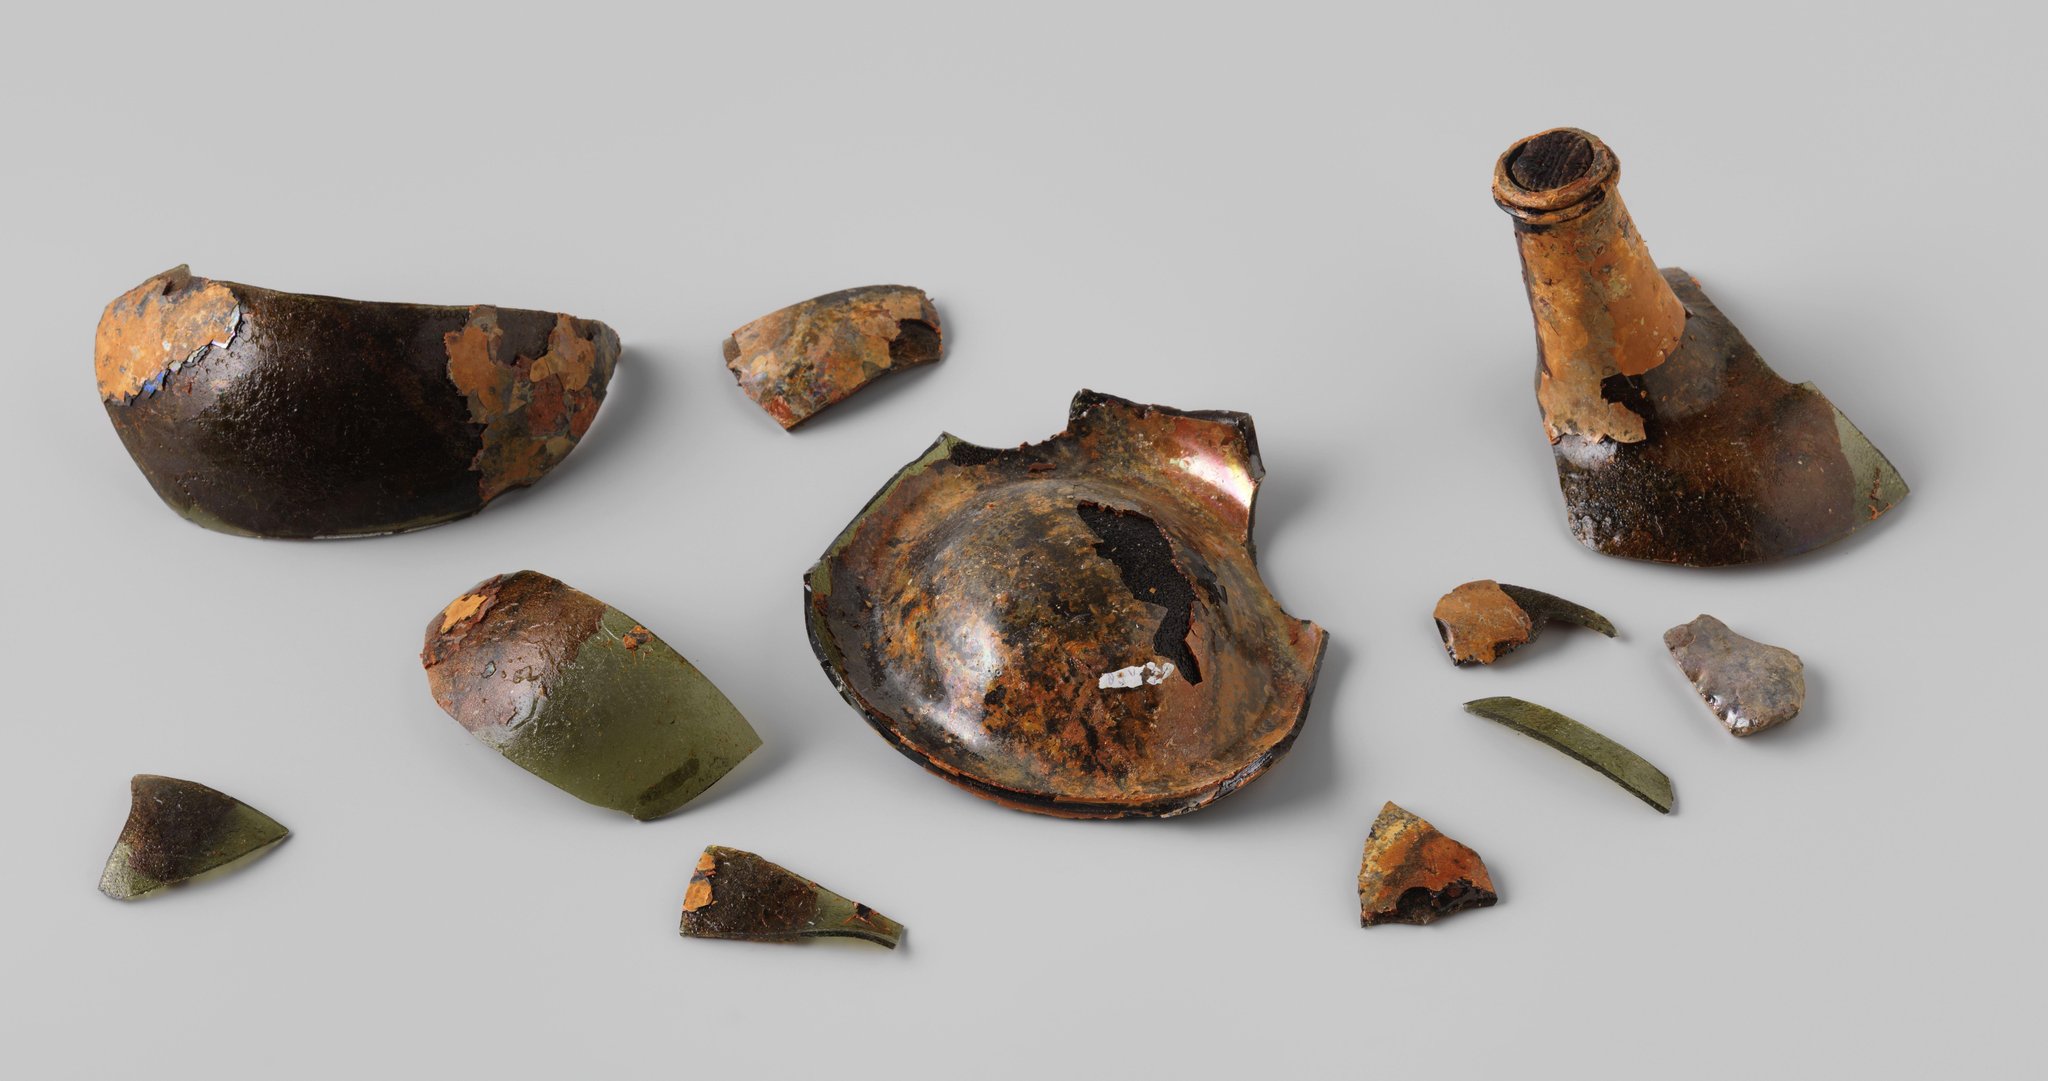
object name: sherd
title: Scherven van wijnflessen uit het wrak van de Oost-Indiëvaarder 't Vliegend Hart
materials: cork, glass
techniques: green glass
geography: netherlands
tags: 't vliegend hart (schip), verenigde oostindische compagnie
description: Scherven van uivormige wijnflessen van groen glas waar rode (port)wijn in heeft gezeten. Hals met kurk.